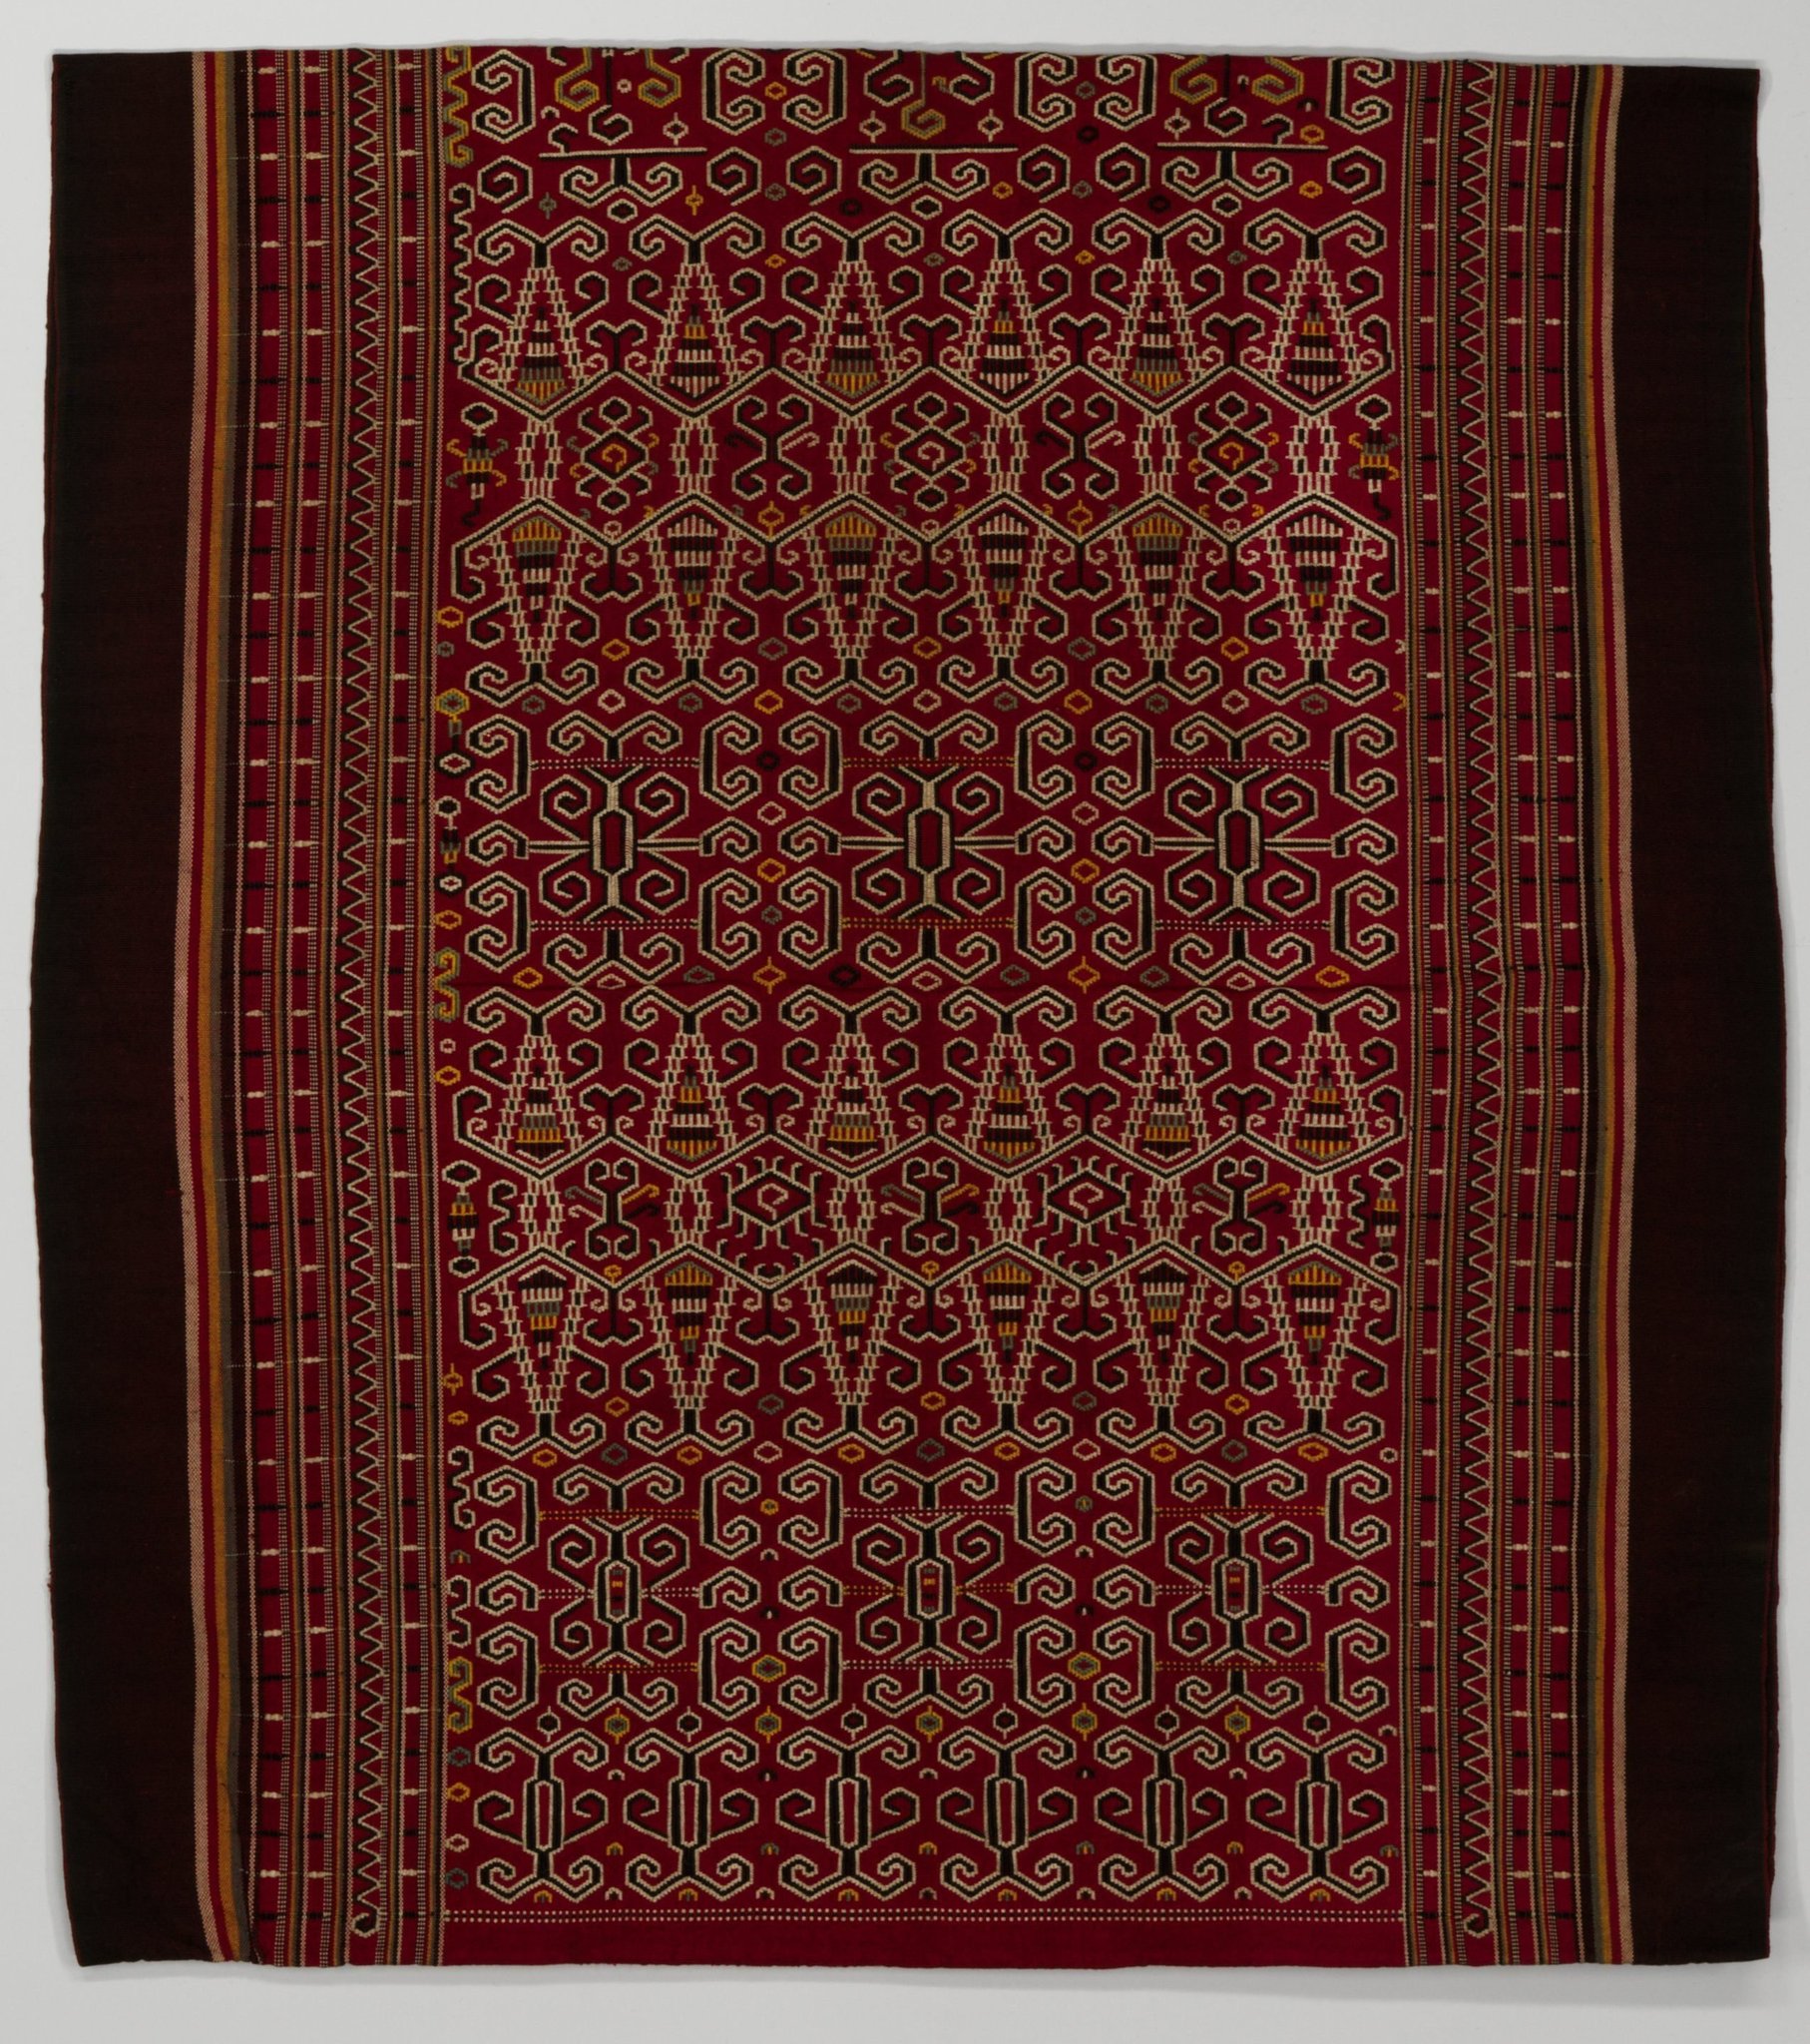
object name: cloth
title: Bidang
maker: Anonymous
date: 1900-1999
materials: cotton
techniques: weave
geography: sarawak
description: Kokerdoek voor een vrouw met gestileerde vogels en eenvoudige c-vormige motieven die de mayan tindok (de slapende kat) voorstellen.